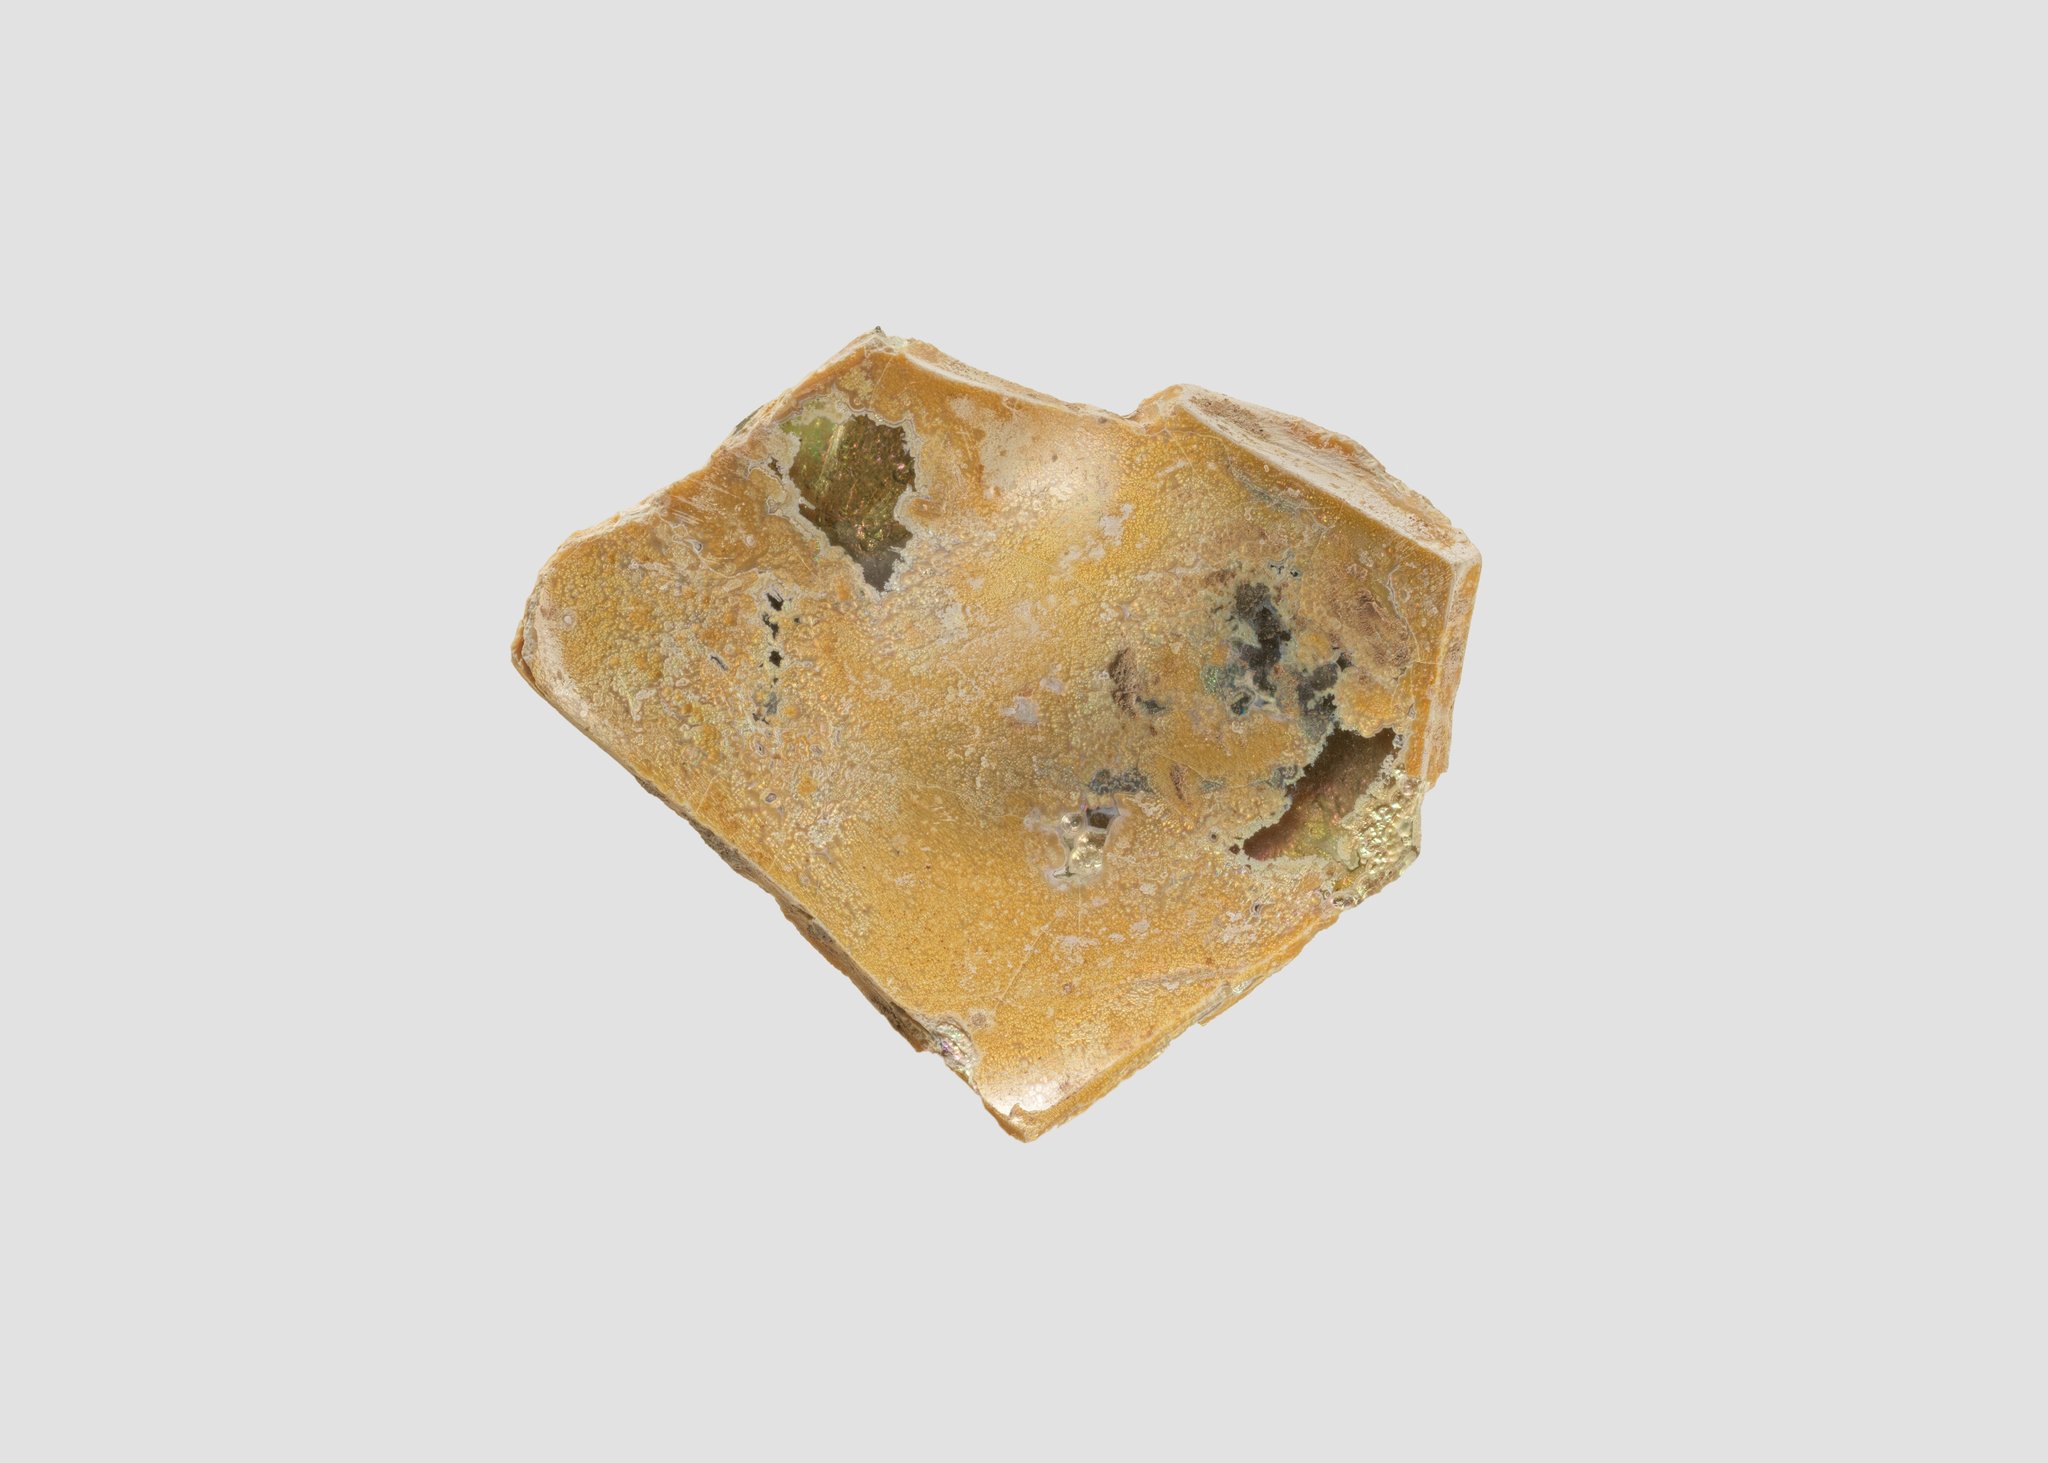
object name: dish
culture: sasanian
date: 201-700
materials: glass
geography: mesopotamia